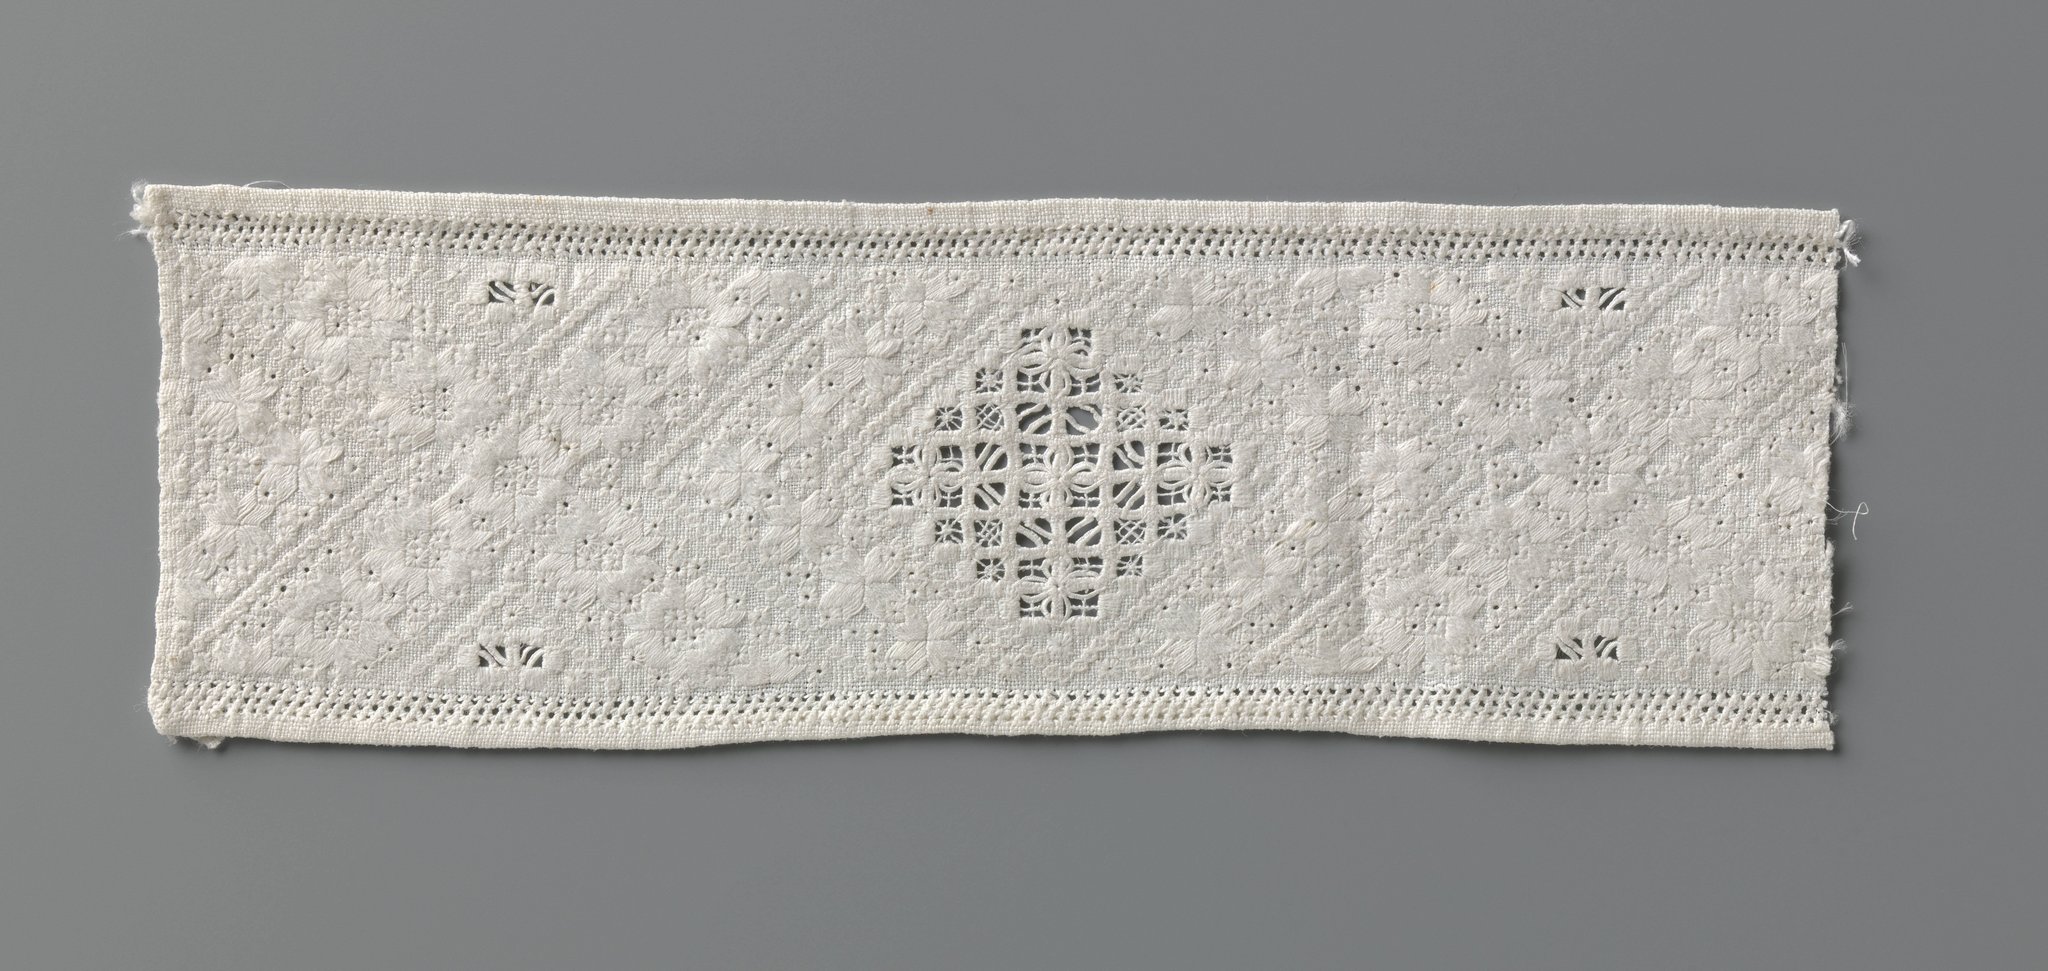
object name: strip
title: Tussenzetsel van geborduurd linnen met kantborduurwerk in een ruit tussen kruizen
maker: Anonymous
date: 1700-1899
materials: linen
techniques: embroidery, embroidered, weave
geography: marken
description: Tussenzetsel van naturelkleurig geborduurd linnen - witwerk - met kantborduurwerk: gesneden werk. Het borduurpatroon bestaat uit een ruit die ontstaat tussen twee kruizen. Zowel de kruizen als de ruit zijn gemaakt met sierbanden waarin geometrische bloemen zijn geborduurd, omringd met talloze zeer kleine uitsparingen. Het opengewerkte centrum van de ruit bestaat uit vierkantjes die uit het linnen zijn gesneden en waarbij de snijranden zijn afgehecht met festonsteken.